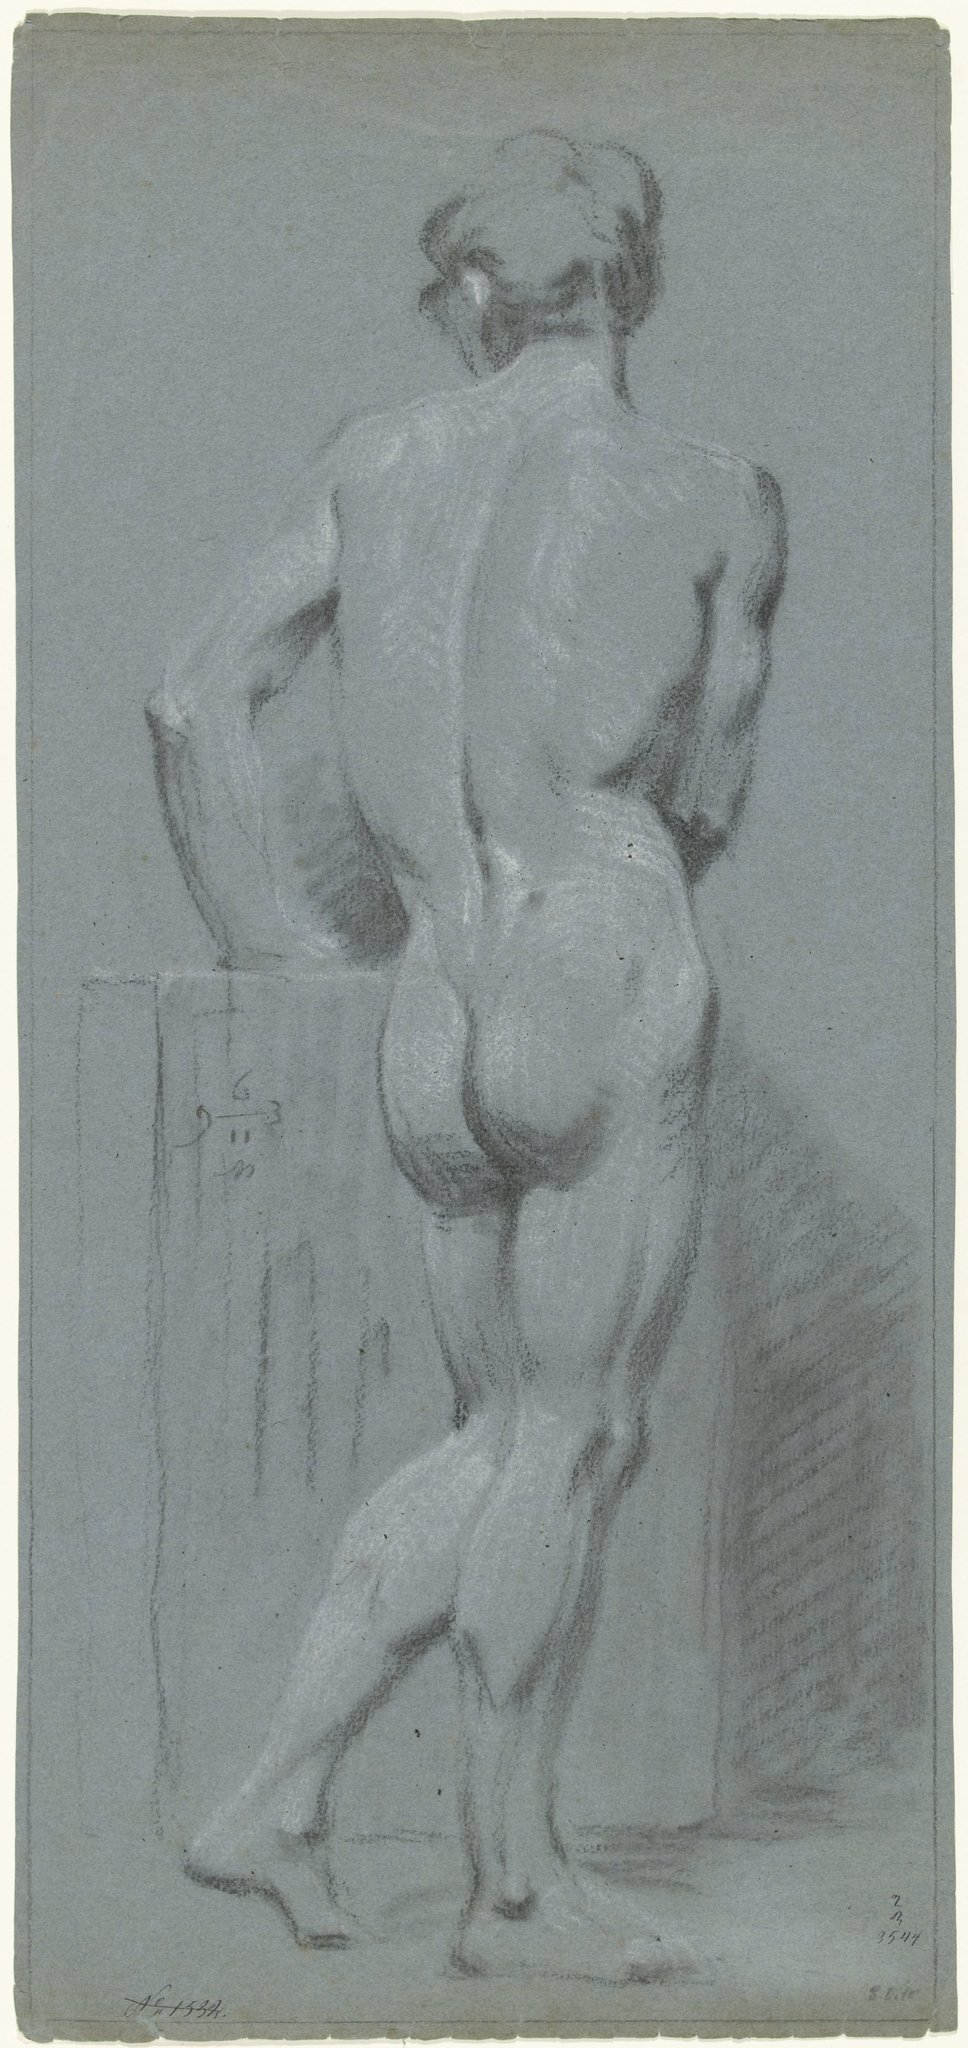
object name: drawing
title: Staand mannelijk naakt, op de rug gezien, iets naar rechts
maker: Anonymous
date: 1793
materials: chalk, paper